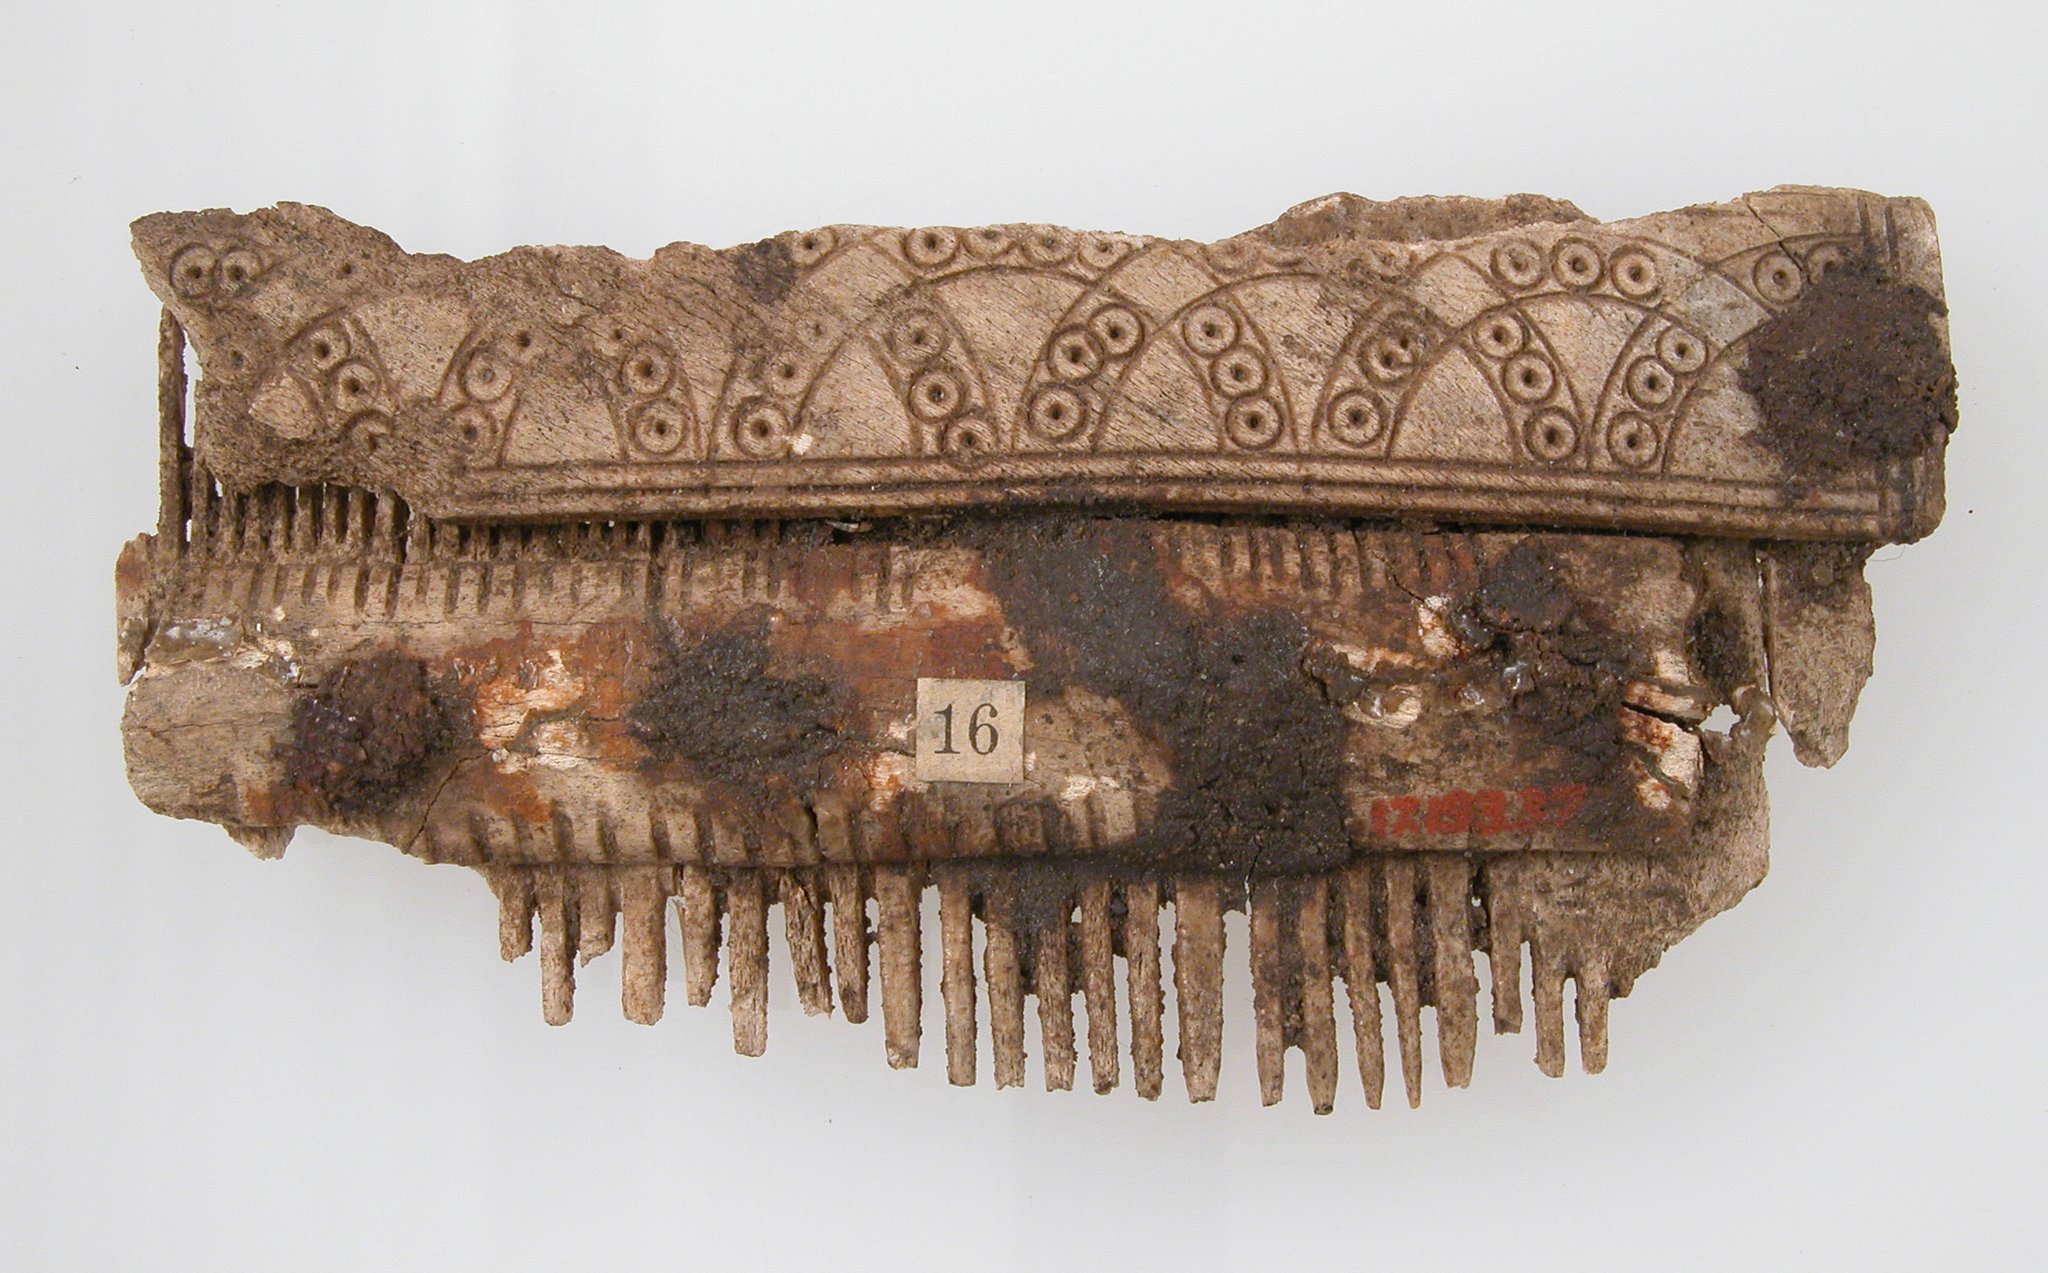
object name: comb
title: Double-Sided Comb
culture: frankish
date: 601-700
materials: bone, iron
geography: germany